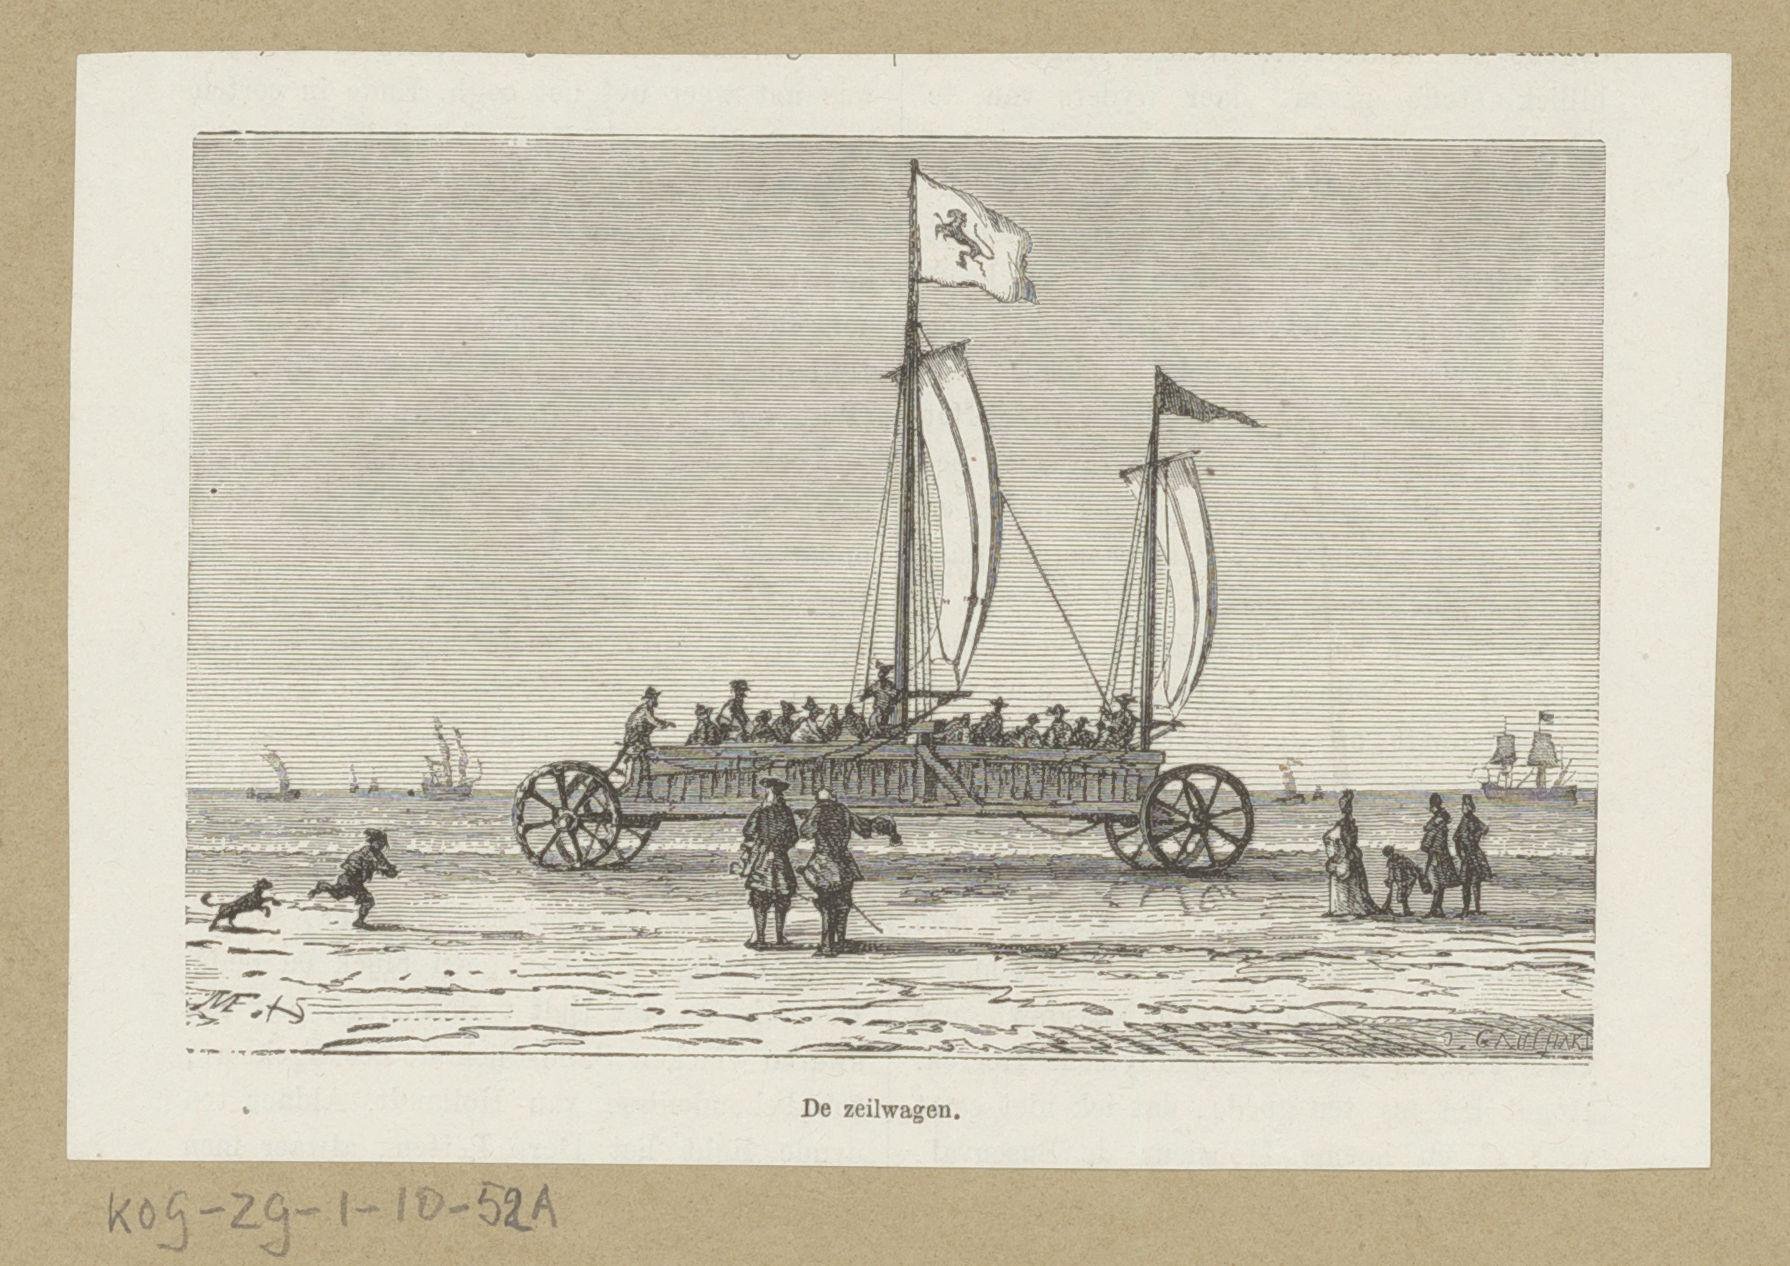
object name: book illustration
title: De zeilwagen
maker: arie cornelis kruseman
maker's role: bookseller, printer, publisher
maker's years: 1818-1894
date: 1869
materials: paper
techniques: letterpress printing, printing block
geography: haarlem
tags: maurice (prince of orange), bruges, simon stevin, sailing-car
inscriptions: stamp, stamp, collector's mark: Lugt 1641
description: Onderwerpsrubrieken binnen de Atlas Zeden en Gewoonten: Vervoermiddelen te land en te water, Vervoermiddelen te land, Zeilwagen van Simon Stevin.